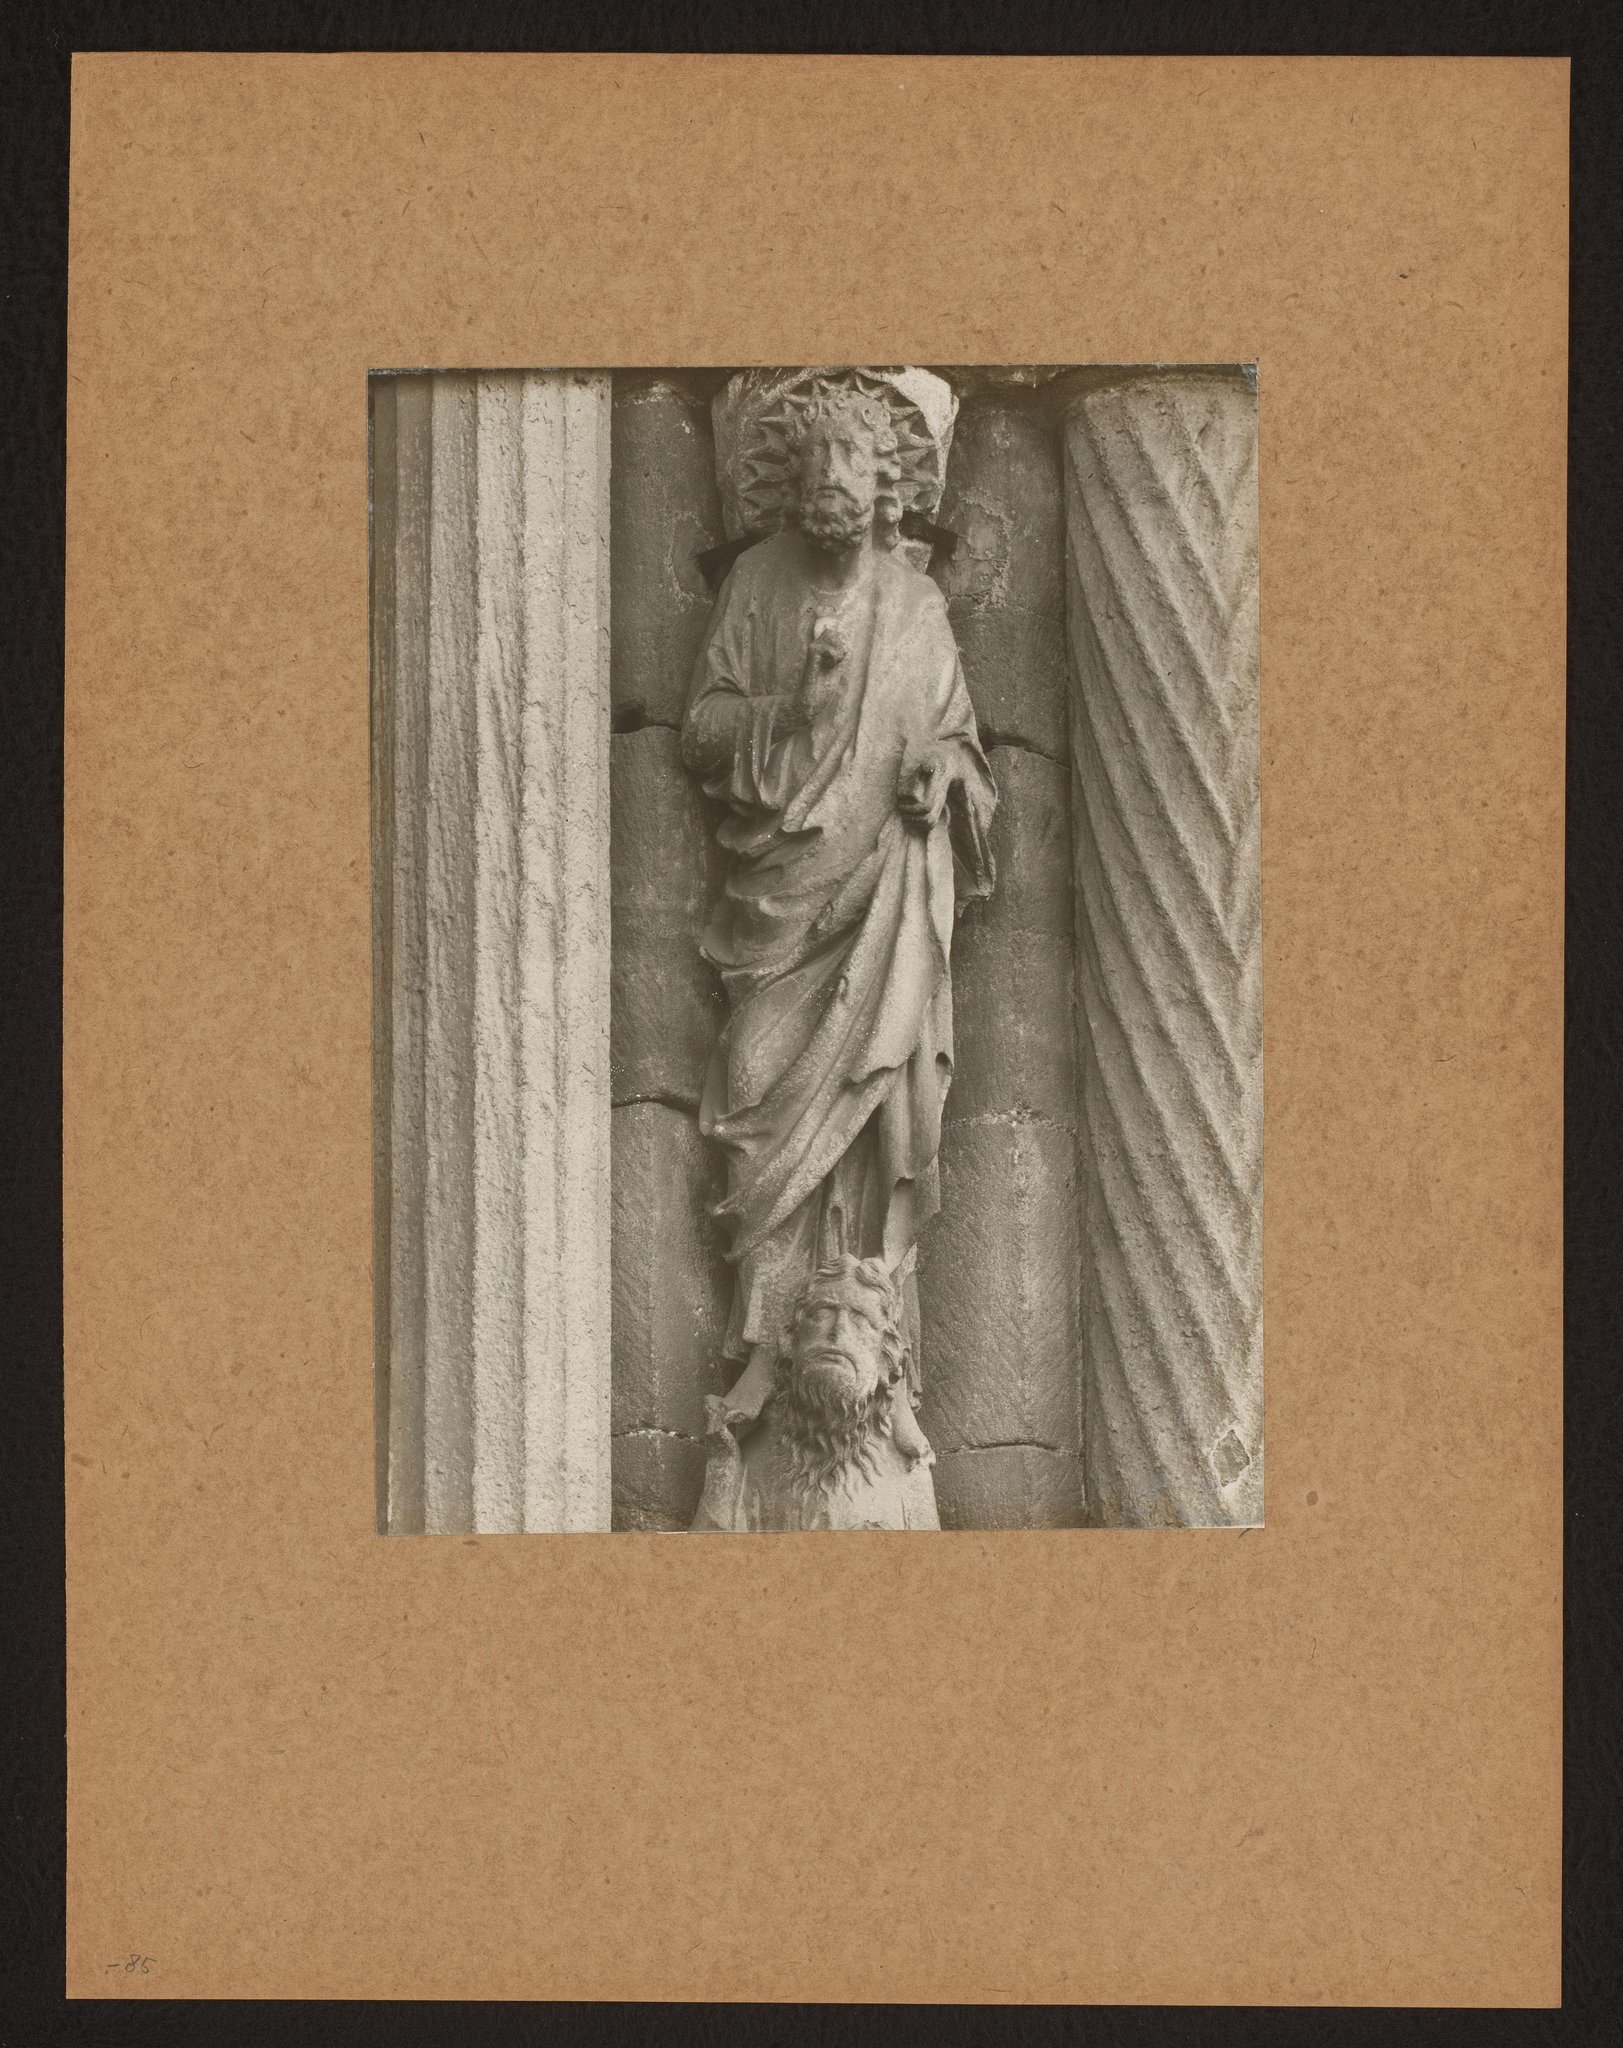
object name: album leaf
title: Detail van het Fürstenportal in de dom van Bamberg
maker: Anonymous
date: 1900-1920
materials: paper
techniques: gelatin silver print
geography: bamberg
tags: church (exterior)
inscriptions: number: ‘87’